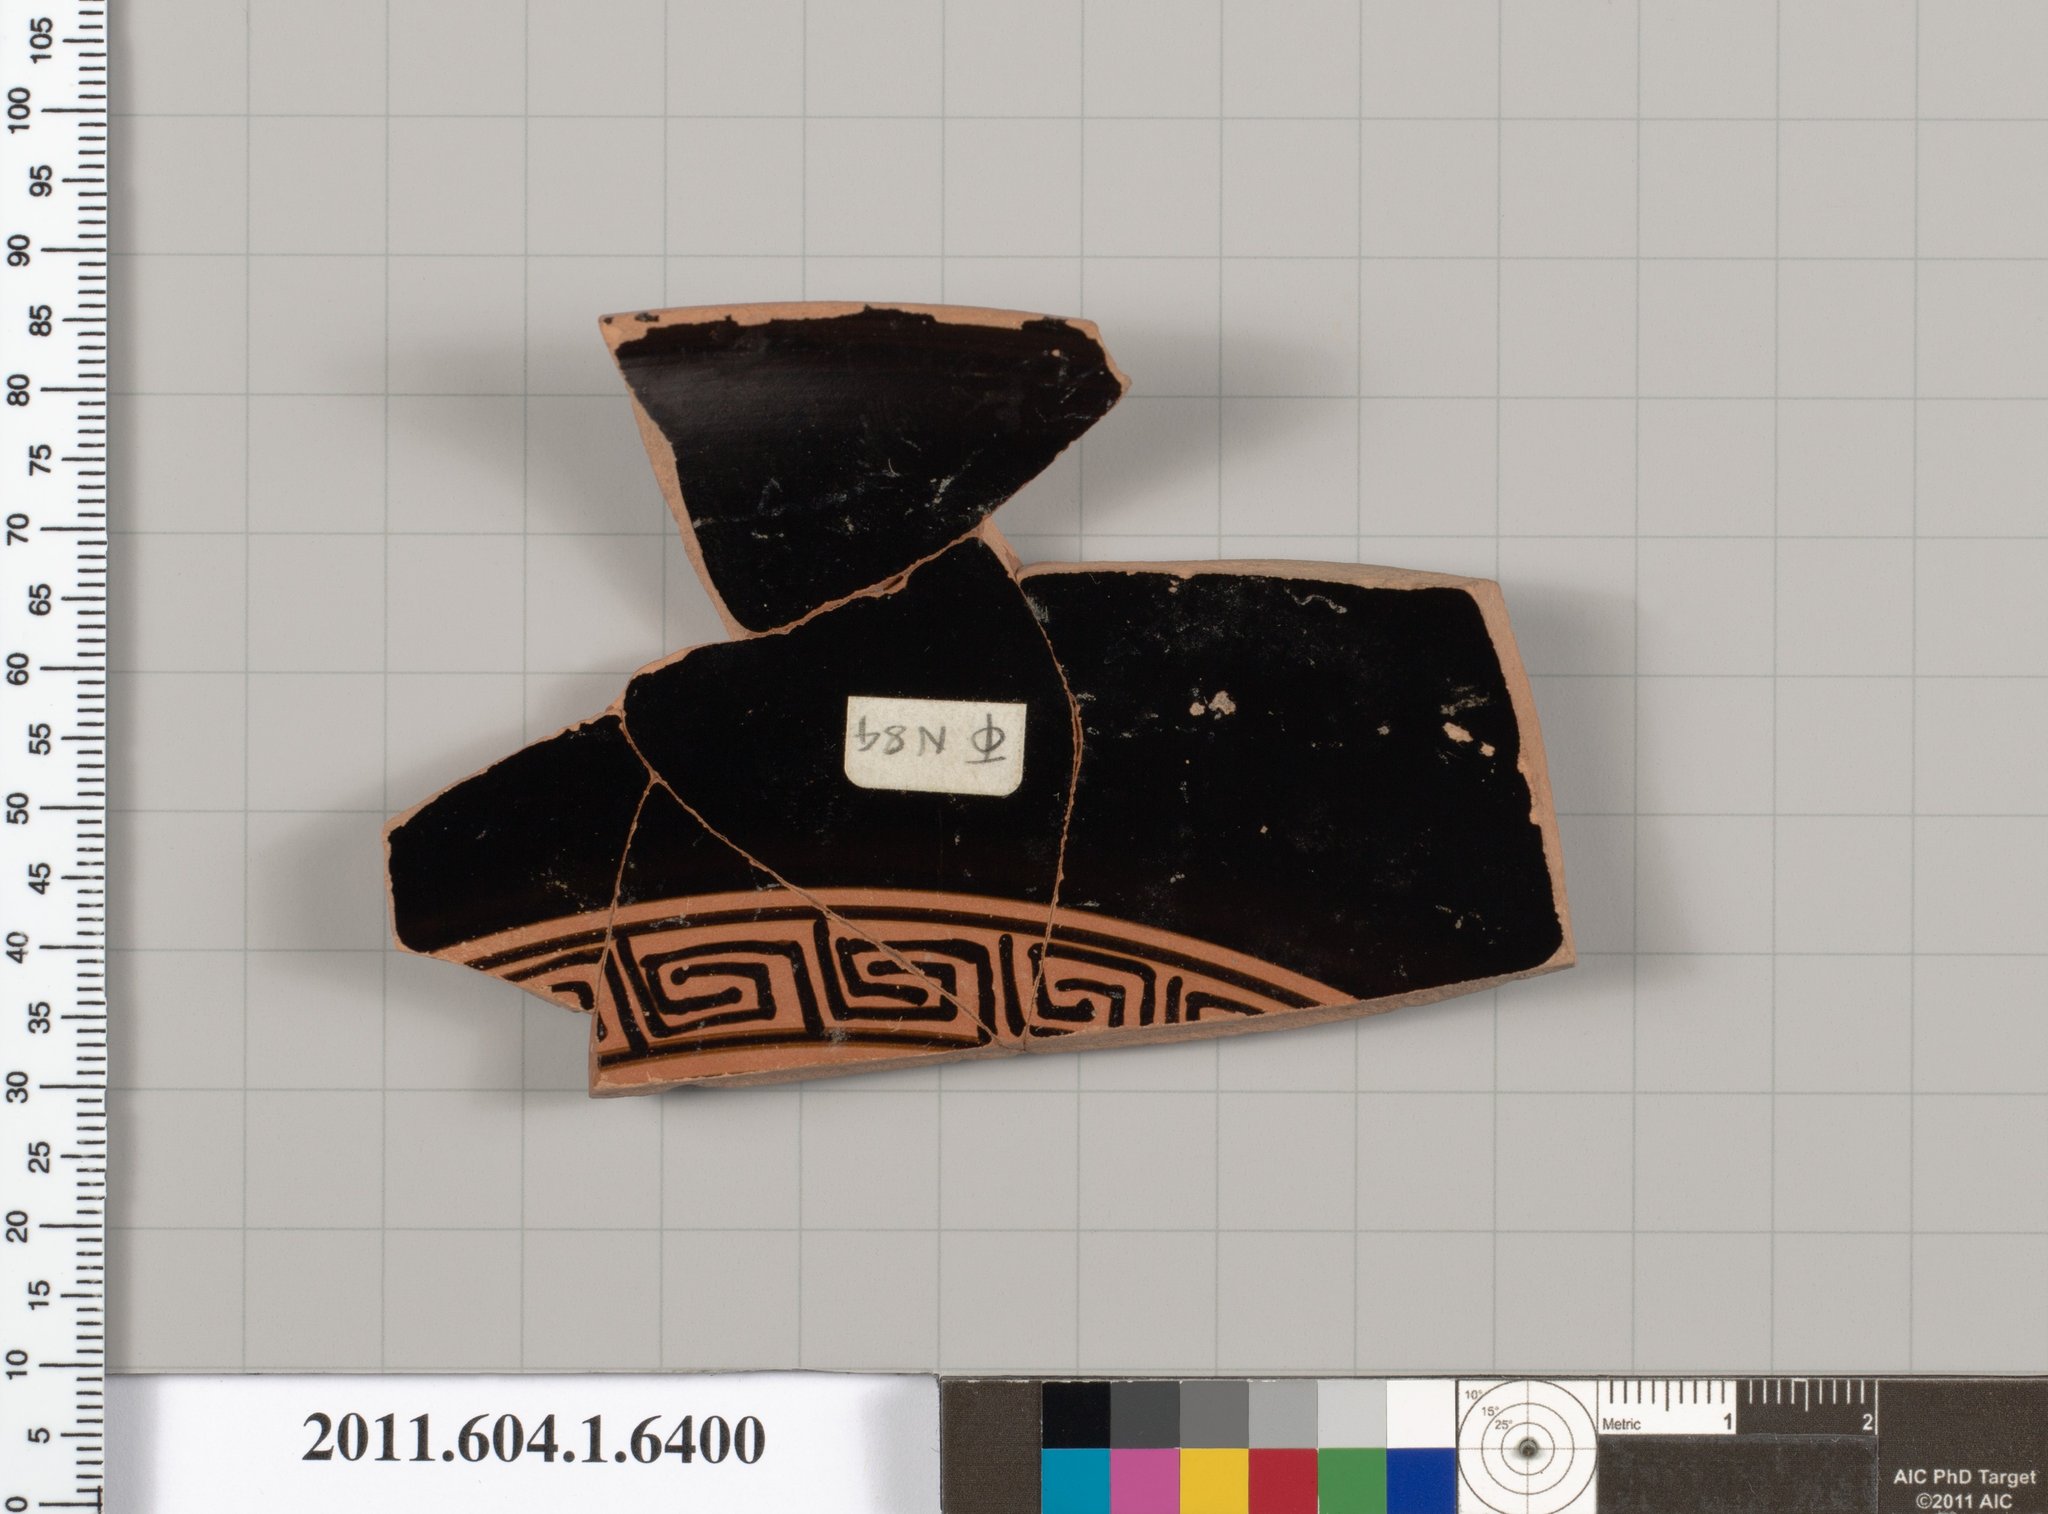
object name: kylix fragment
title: Terracotta rim fragment of a kylix (drinking cup)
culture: greek, attic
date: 490-480 BCE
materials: terracotta